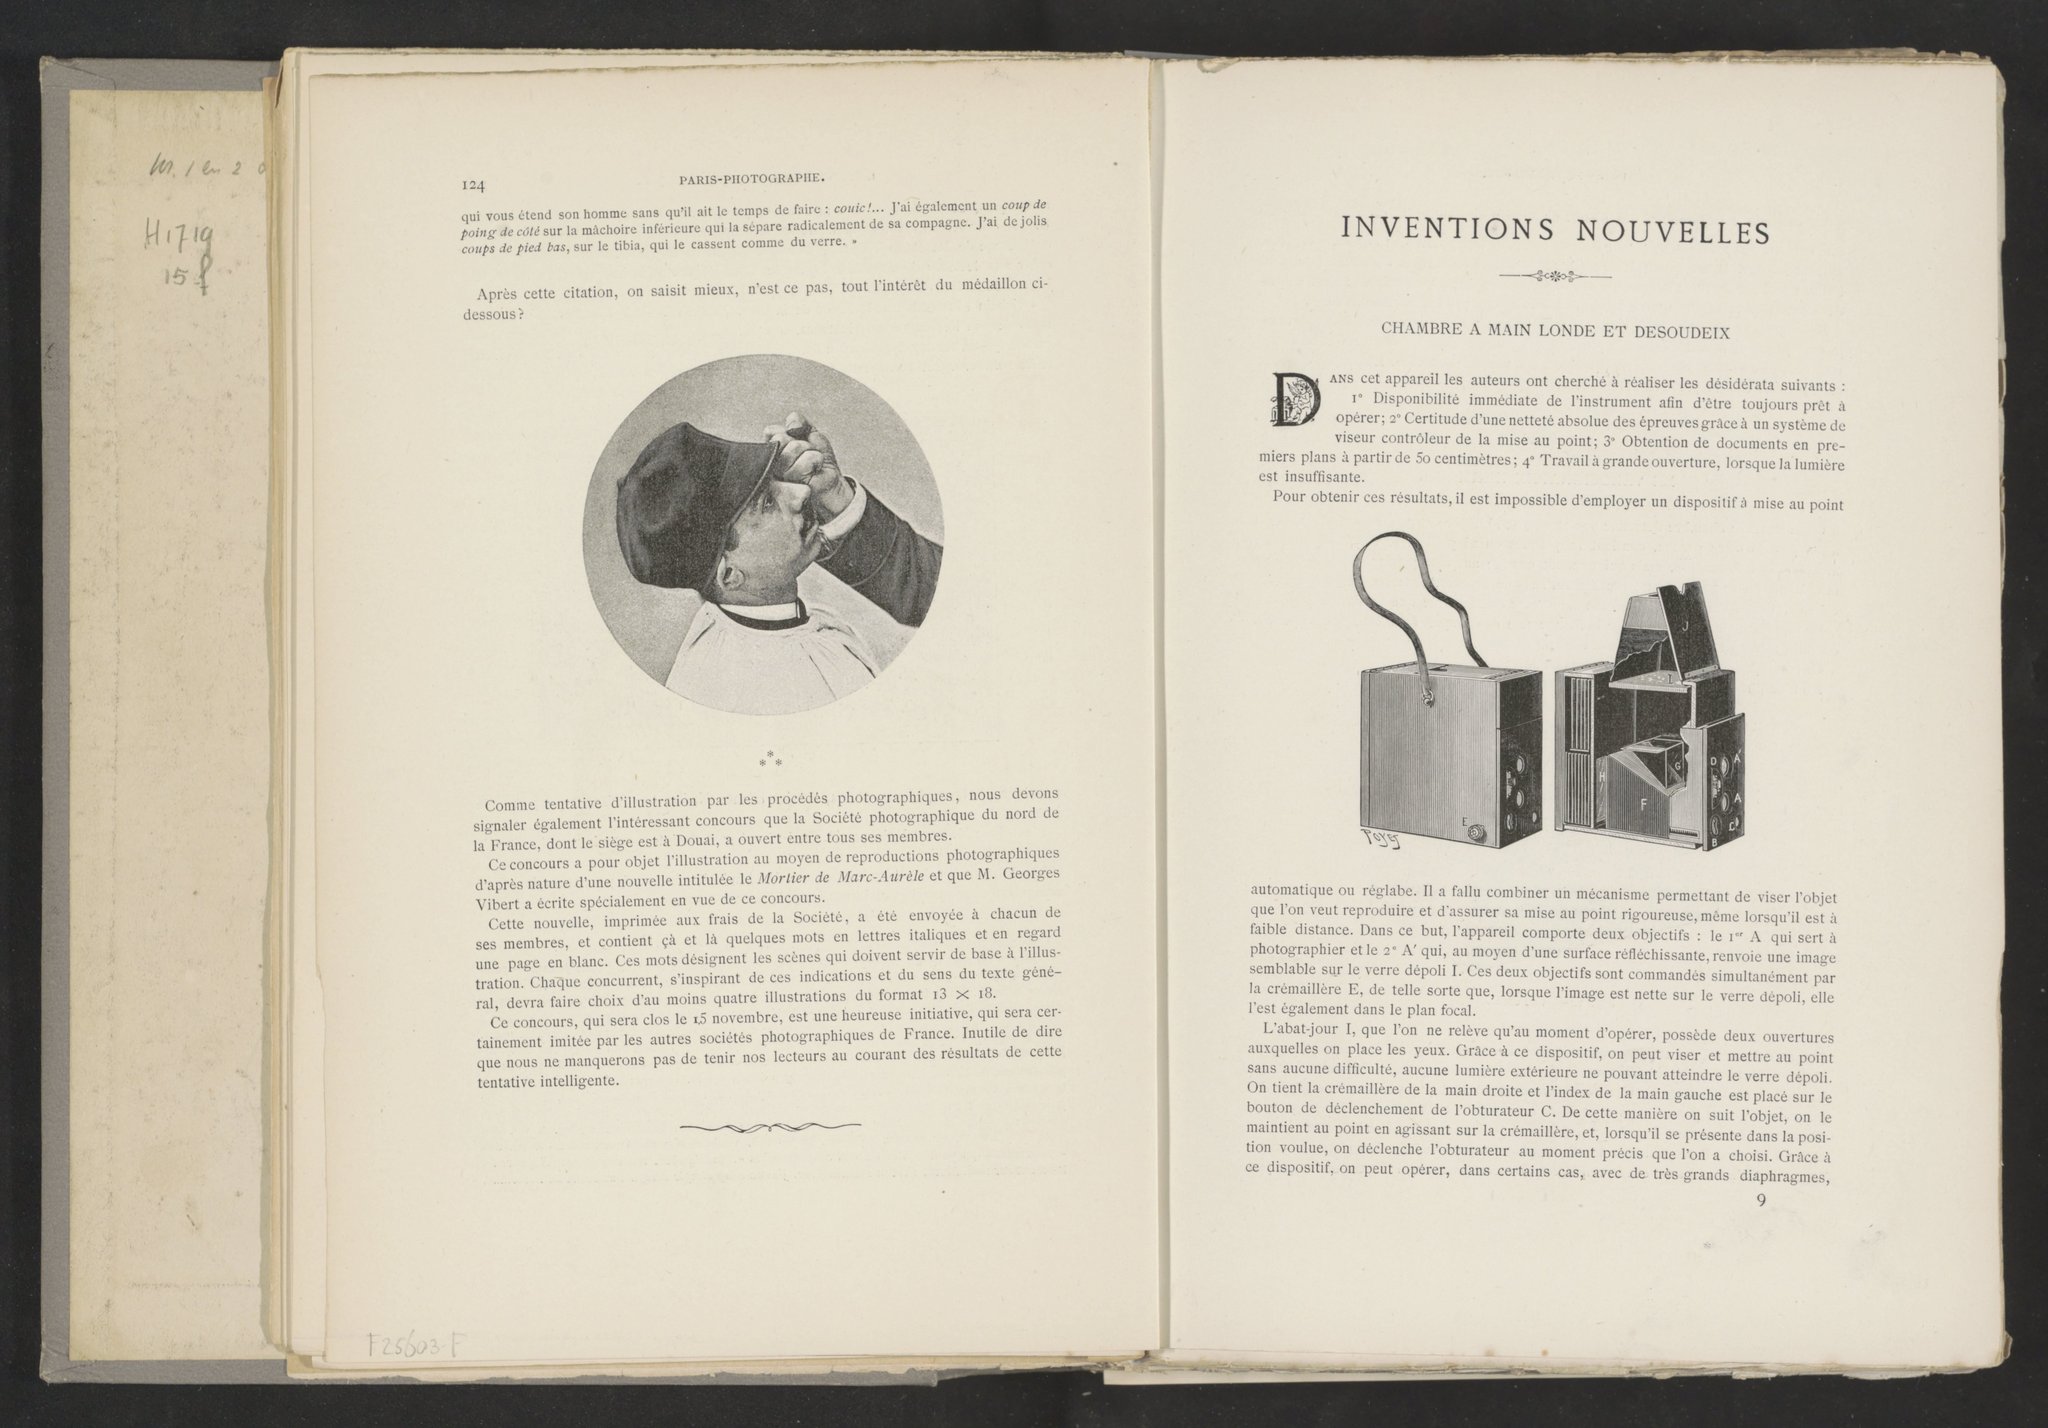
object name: page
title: Man wordt in het gezicht geslagen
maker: Anonymous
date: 1881-1891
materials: paper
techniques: autotype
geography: france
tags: head (human), hitting at something